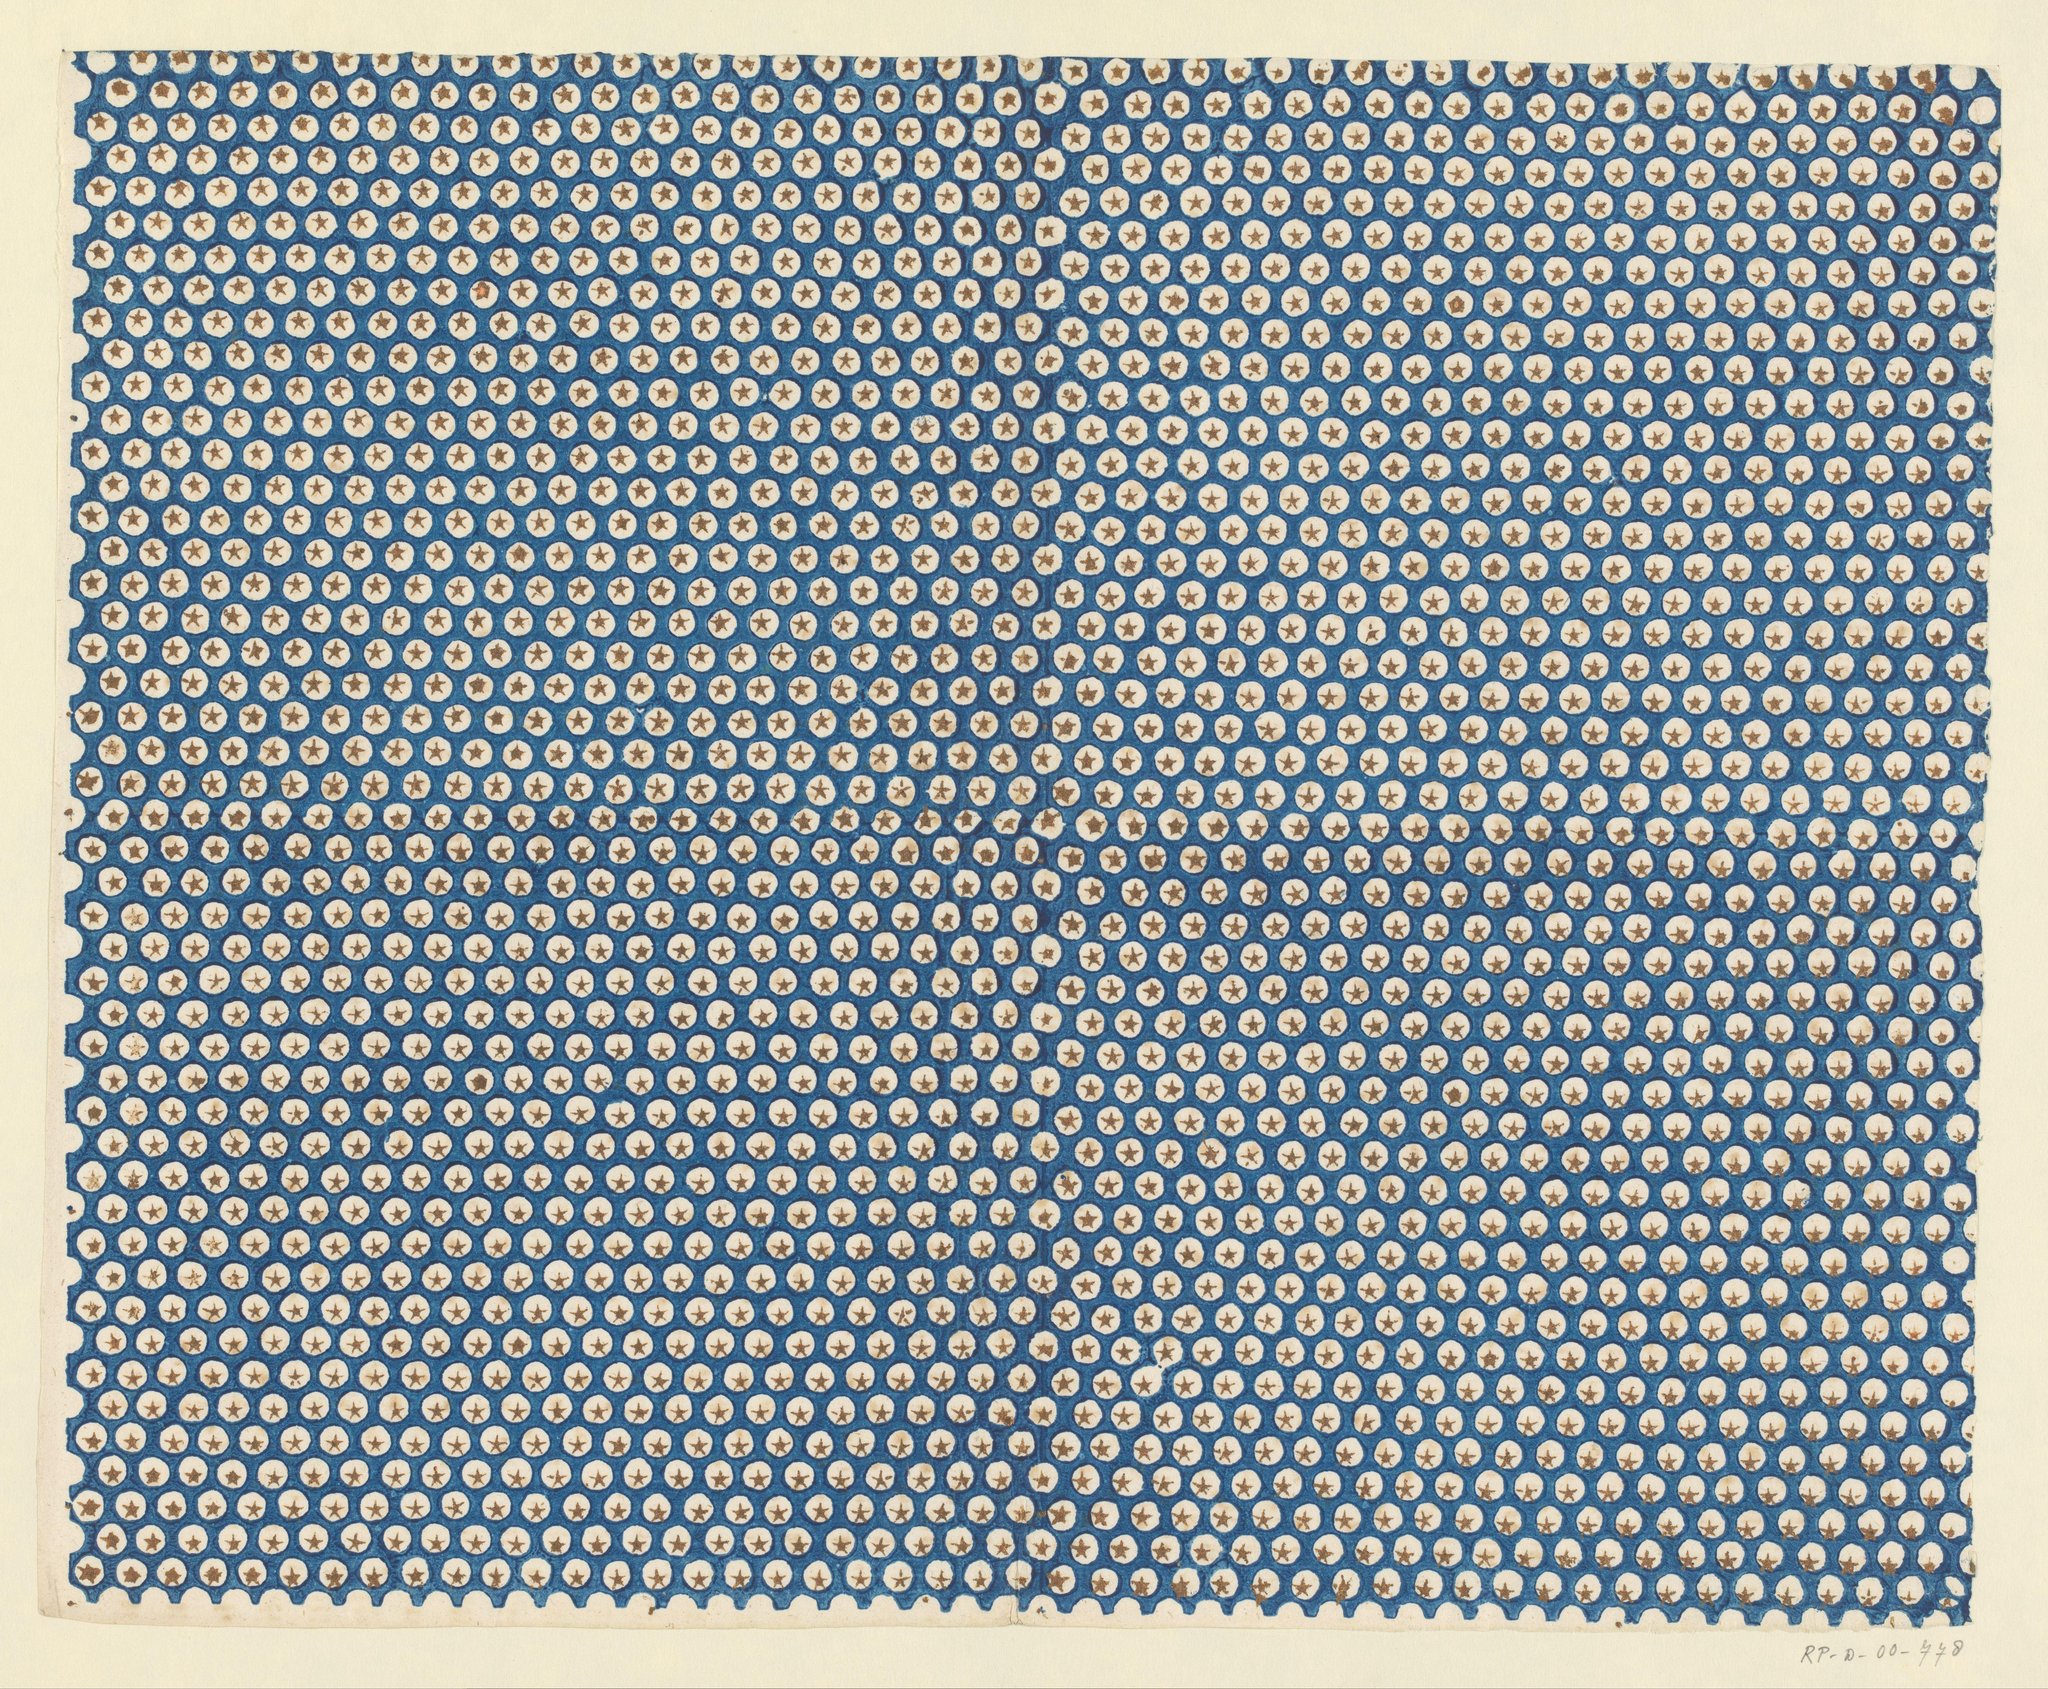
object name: printed paper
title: Blad met strooipatroon van sterren in uitgespaarde cirkels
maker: Anonymous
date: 1750-1950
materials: paint, paper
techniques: printing block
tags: ornament ~ starforms